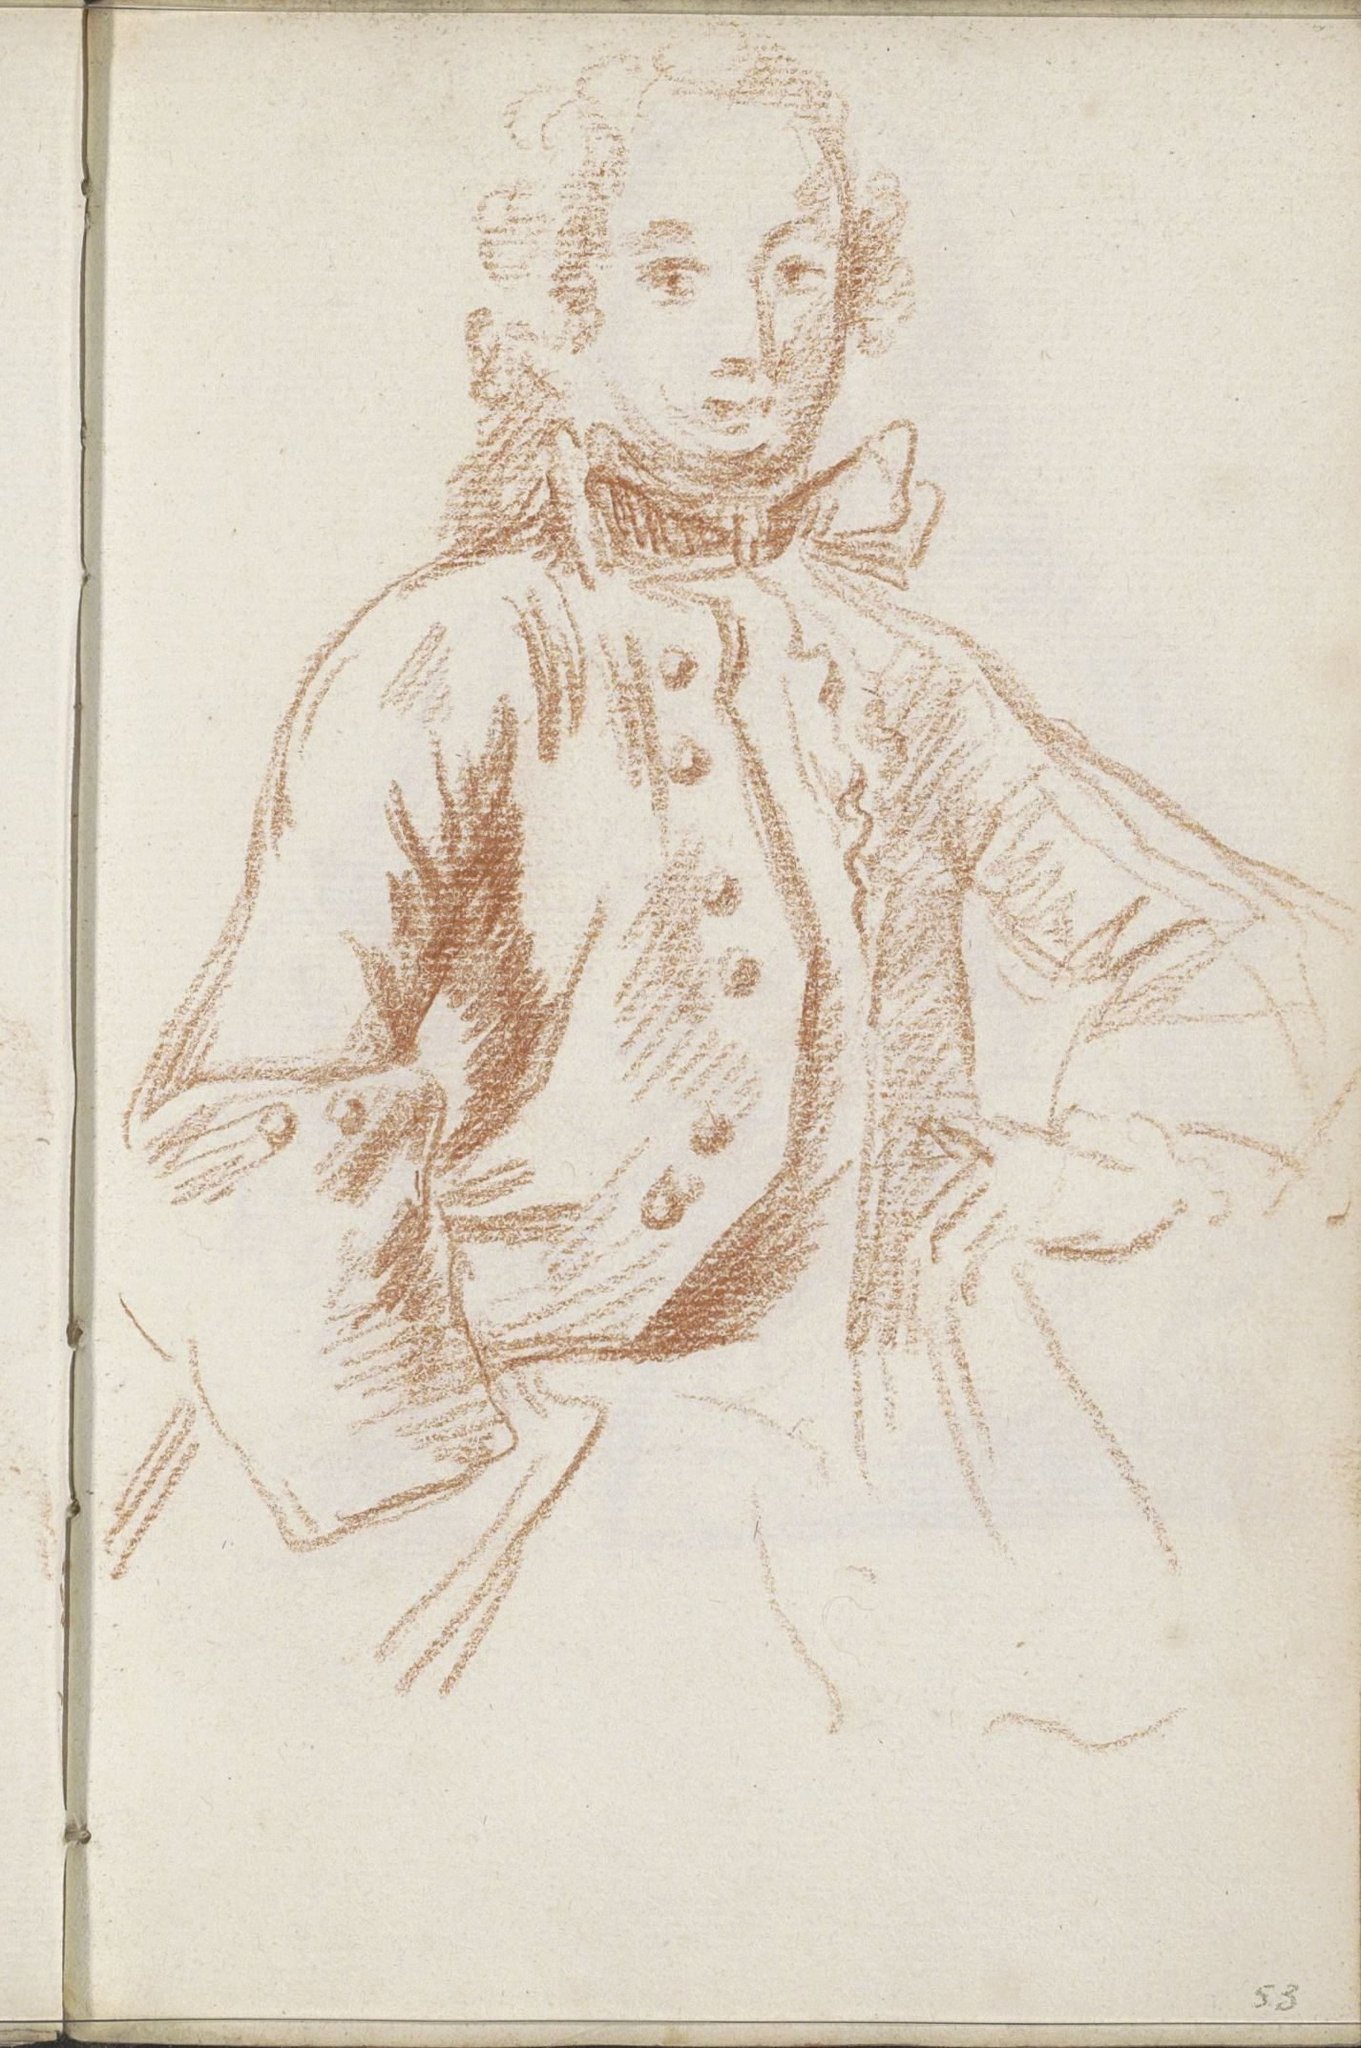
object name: sketchbook leaf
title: Staande man met de hand op de heup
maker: petrus johannes van reysschoot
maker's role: draughtsman, print maker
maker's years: 1702-1772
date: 1710-1772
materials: chalk, paper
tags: hand on the hip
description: Blad 53 recto uit een schetsboek met 105 bladen.